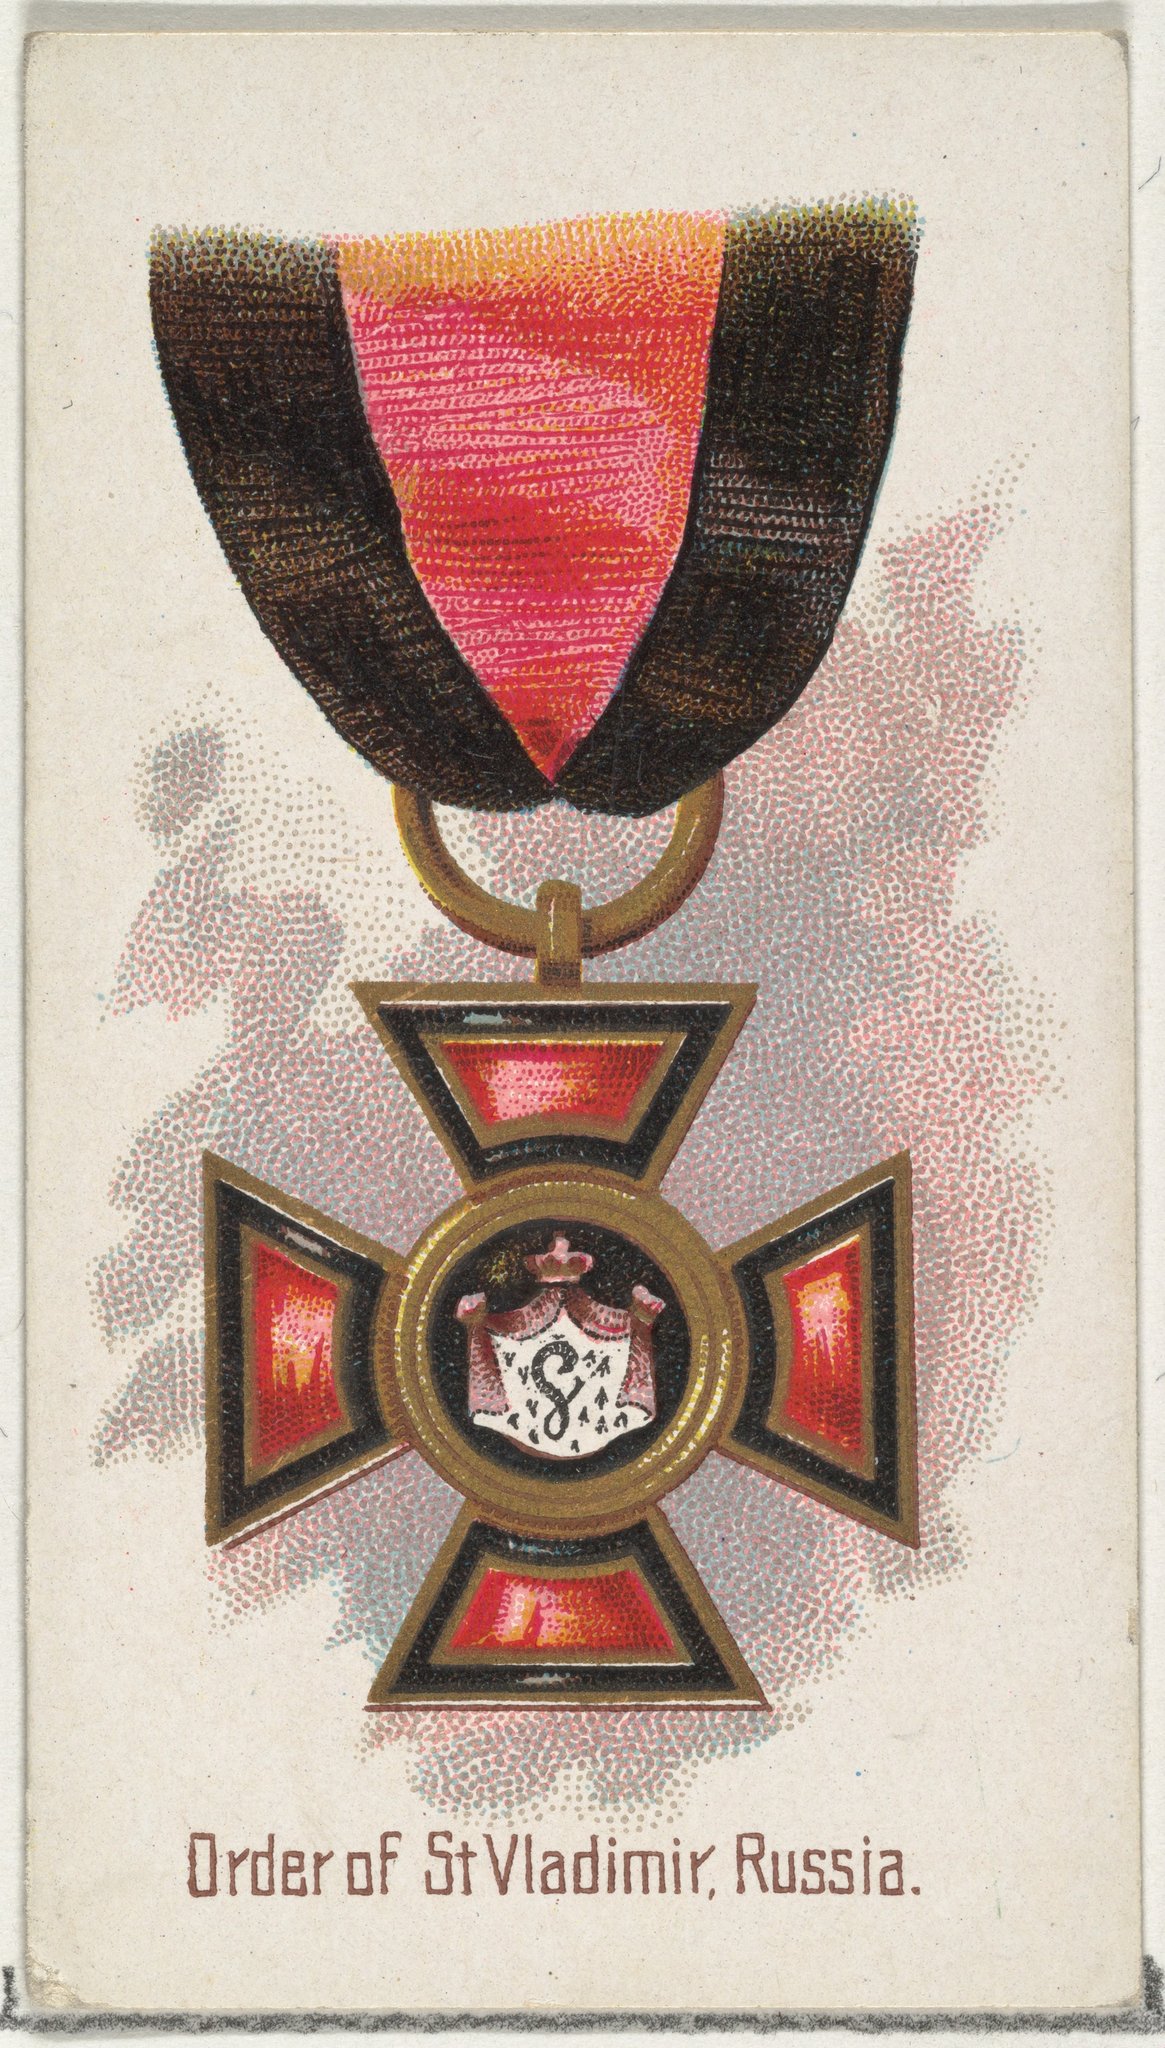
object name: print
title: Order of St. Vladimir, Russia, from the World's Decorations series (N30) for Allen & Ginter Cigarettes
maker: allen & ginter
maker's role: publisher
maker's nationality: american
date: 1890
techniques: color lithograph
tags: medals